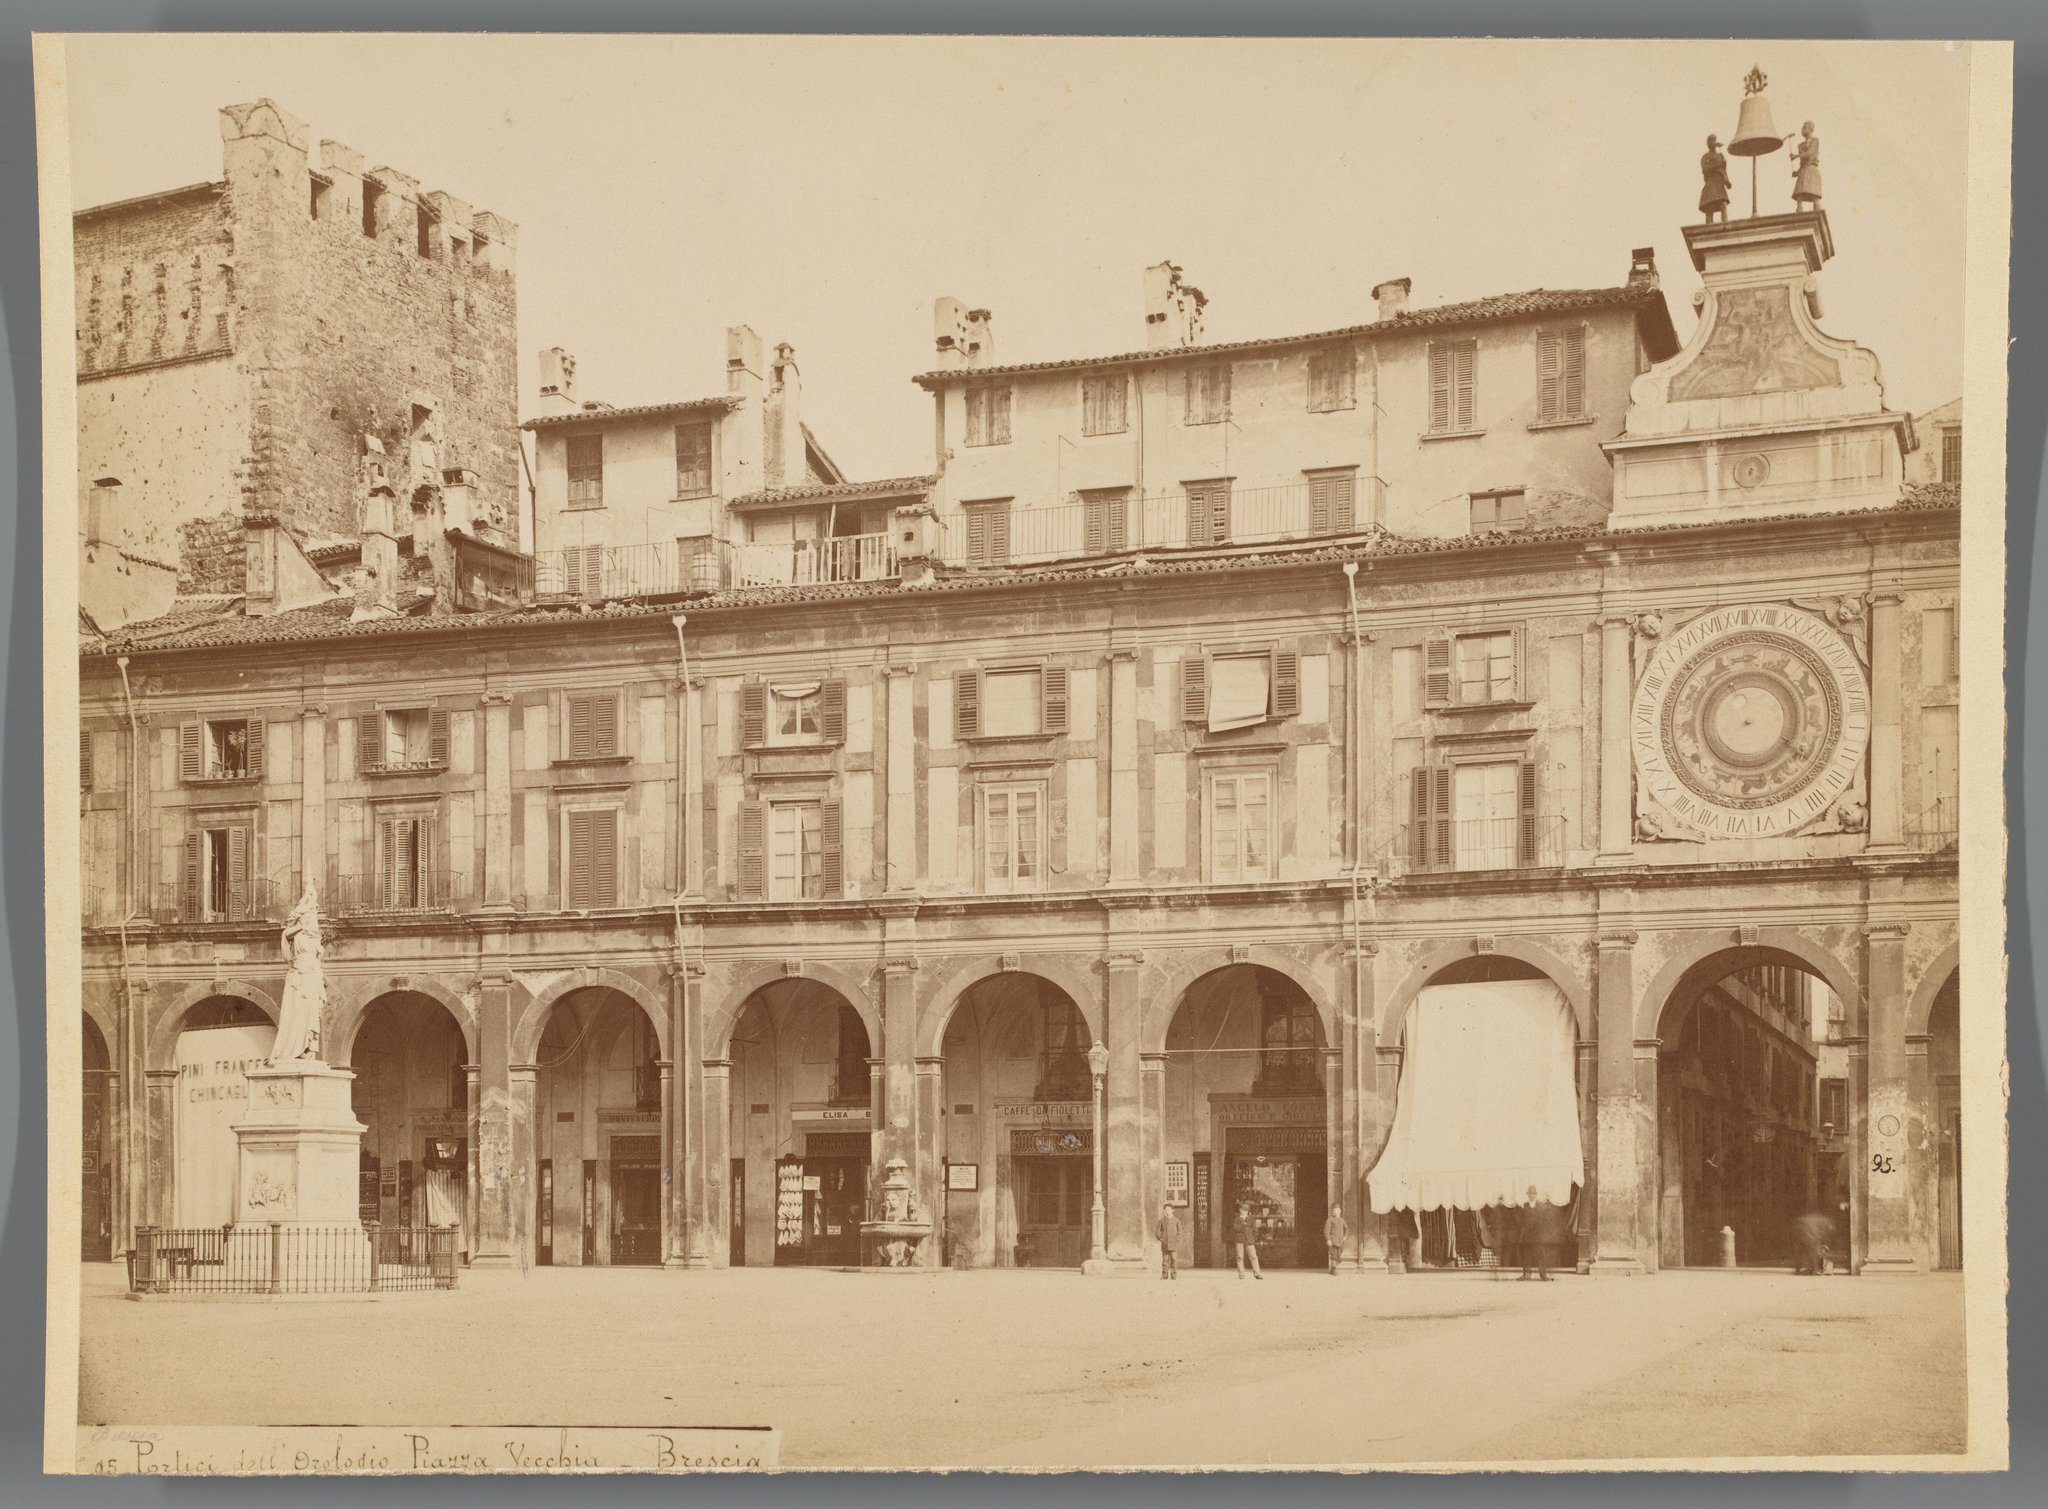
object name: photograph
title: Italië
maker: Anonymous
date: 1880-1910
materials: photographic support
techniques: albumen print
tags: italy